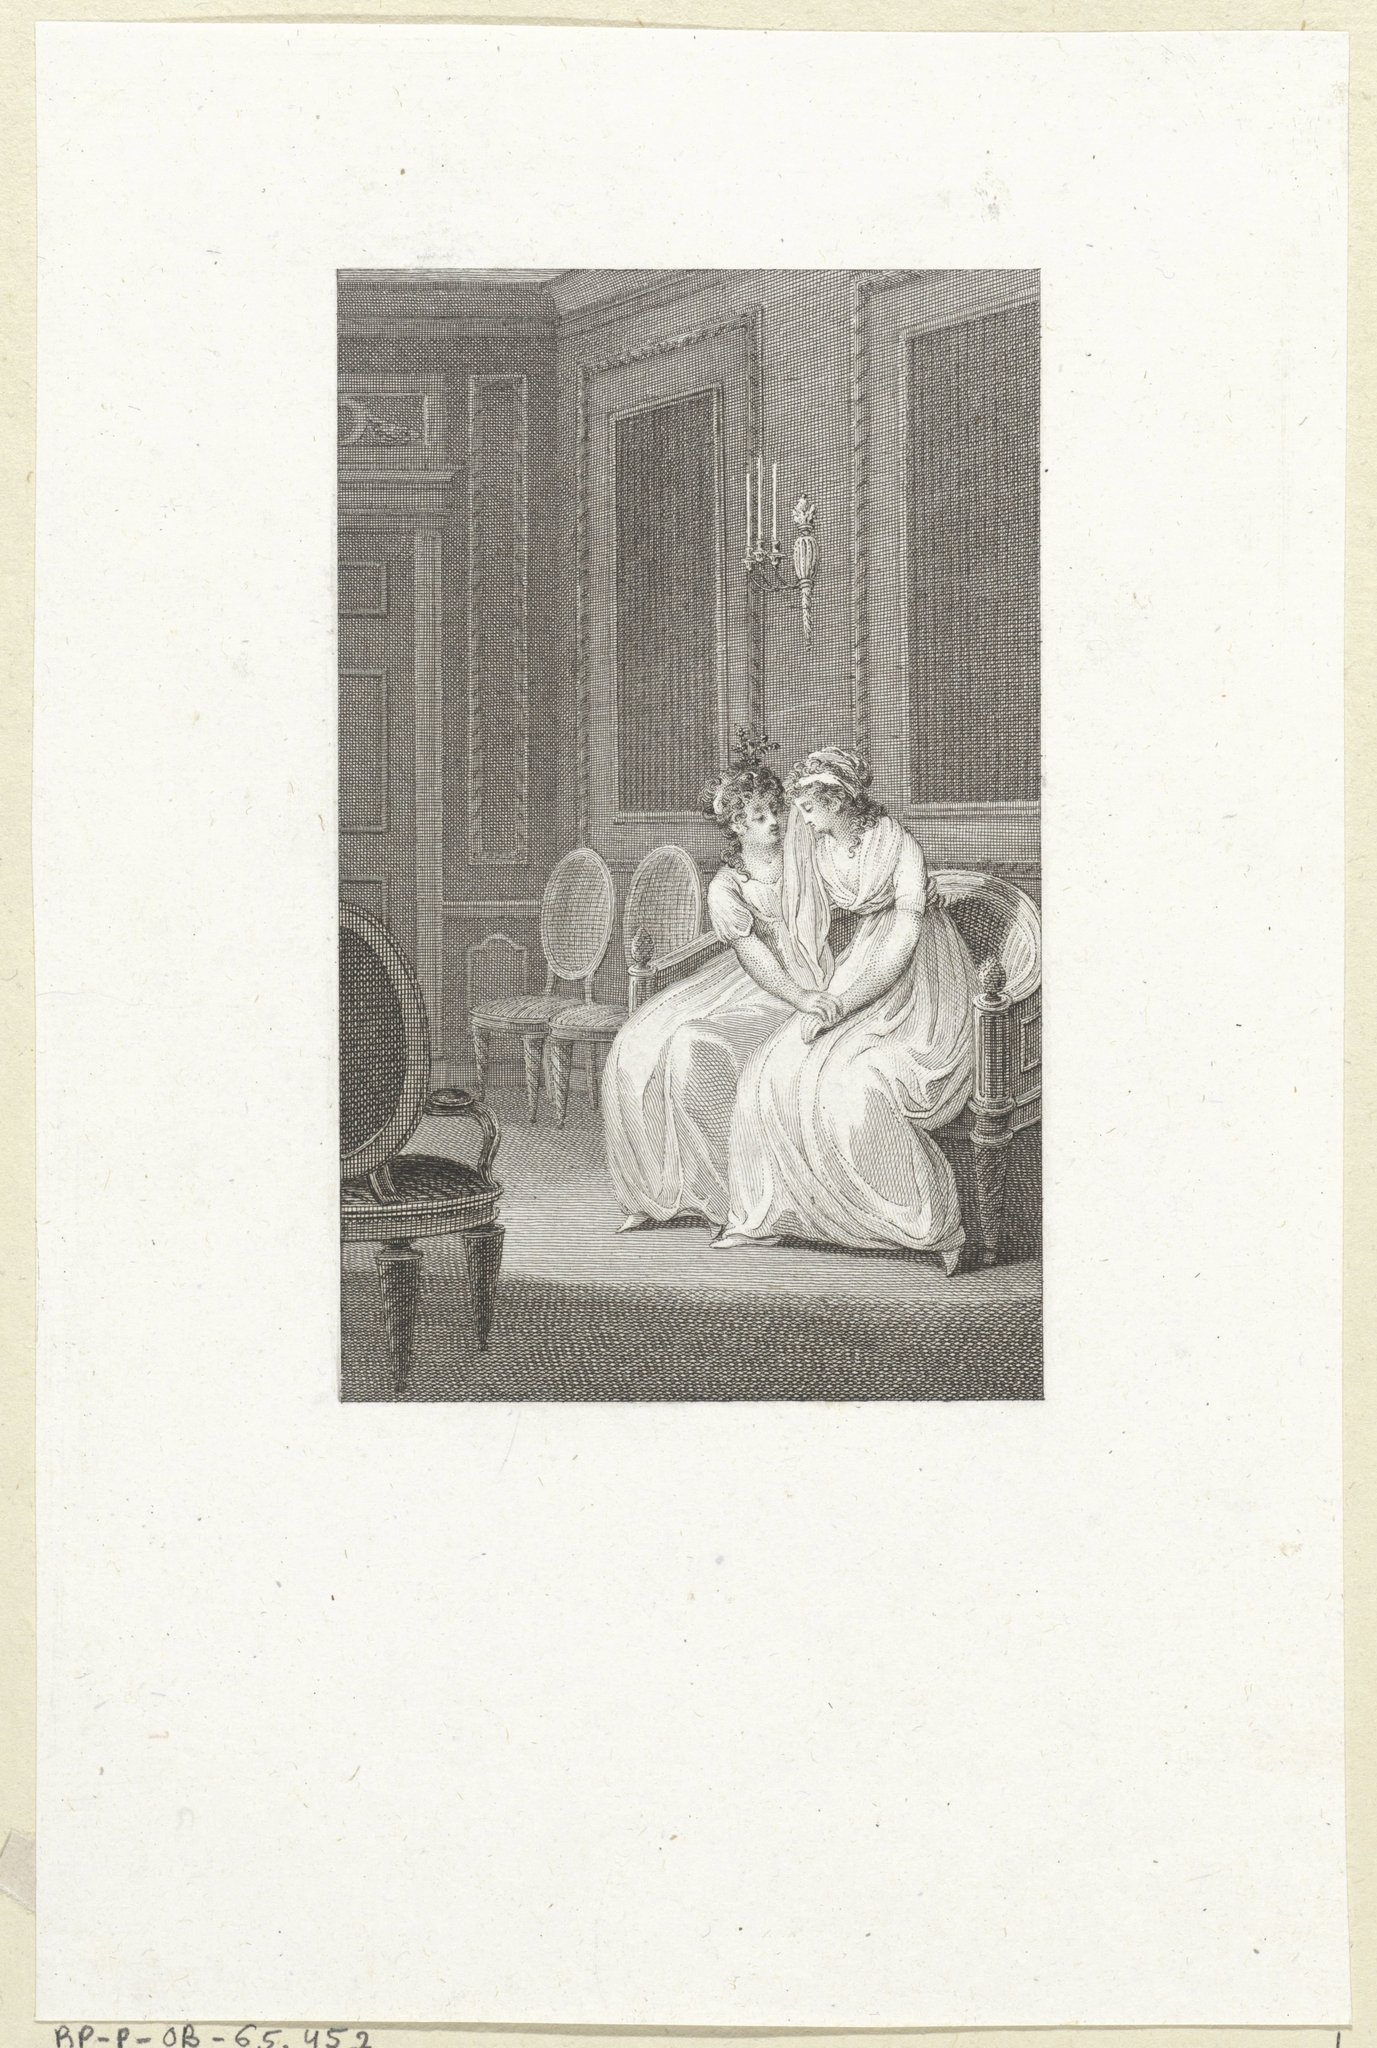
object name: print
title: Jonge vrouw troost haar huilende vriendin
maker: reinier vinkeles (i)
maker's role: draughtsman, print maker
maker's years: 1741-1816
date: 1751-1816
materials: paper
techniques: engraving, etching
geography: amsterdam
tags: comforter (weaning), friends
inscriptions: collector's mark: Lugt 240